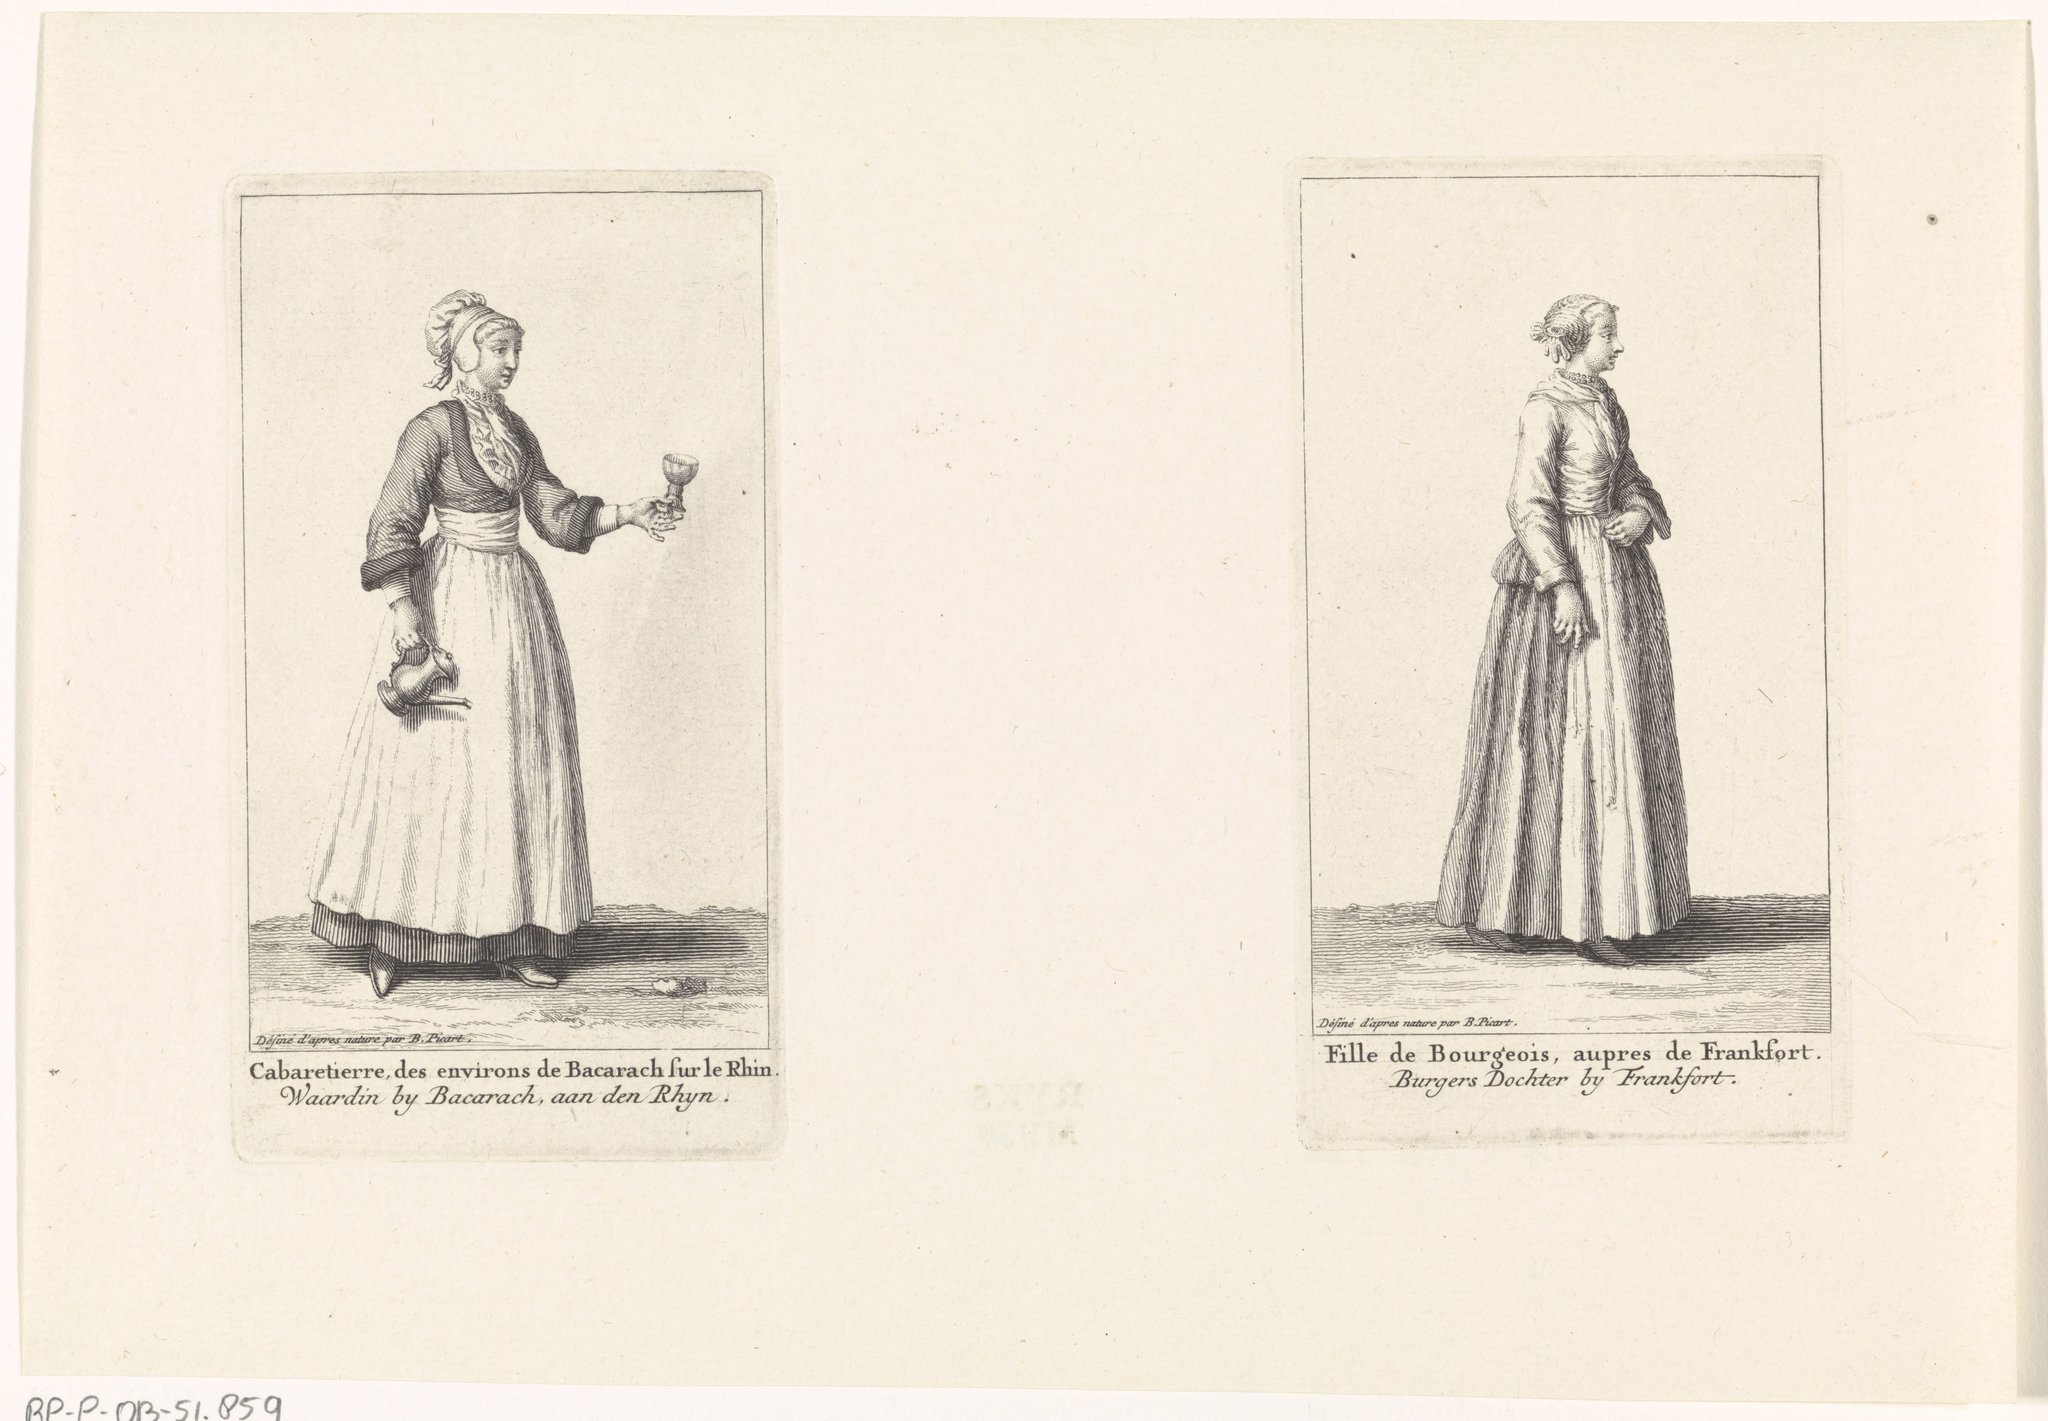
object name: print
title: Waardin uit Bacharach aan de Rijn en burgermeisje uit Frankfurt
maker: bernard picart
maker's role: draughtsman, print maker, publisher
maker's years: 1673-1733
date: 1728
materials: paper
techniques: engraving, etching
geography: amsterdam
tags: folk costume, regional costume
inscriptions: collector's mark: Lugt 2165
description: Onversneden blad met twee prenten met voorstellingen van figuren in klederdracht. De prenten hebben een titel in het Frans en in het Nederlands.